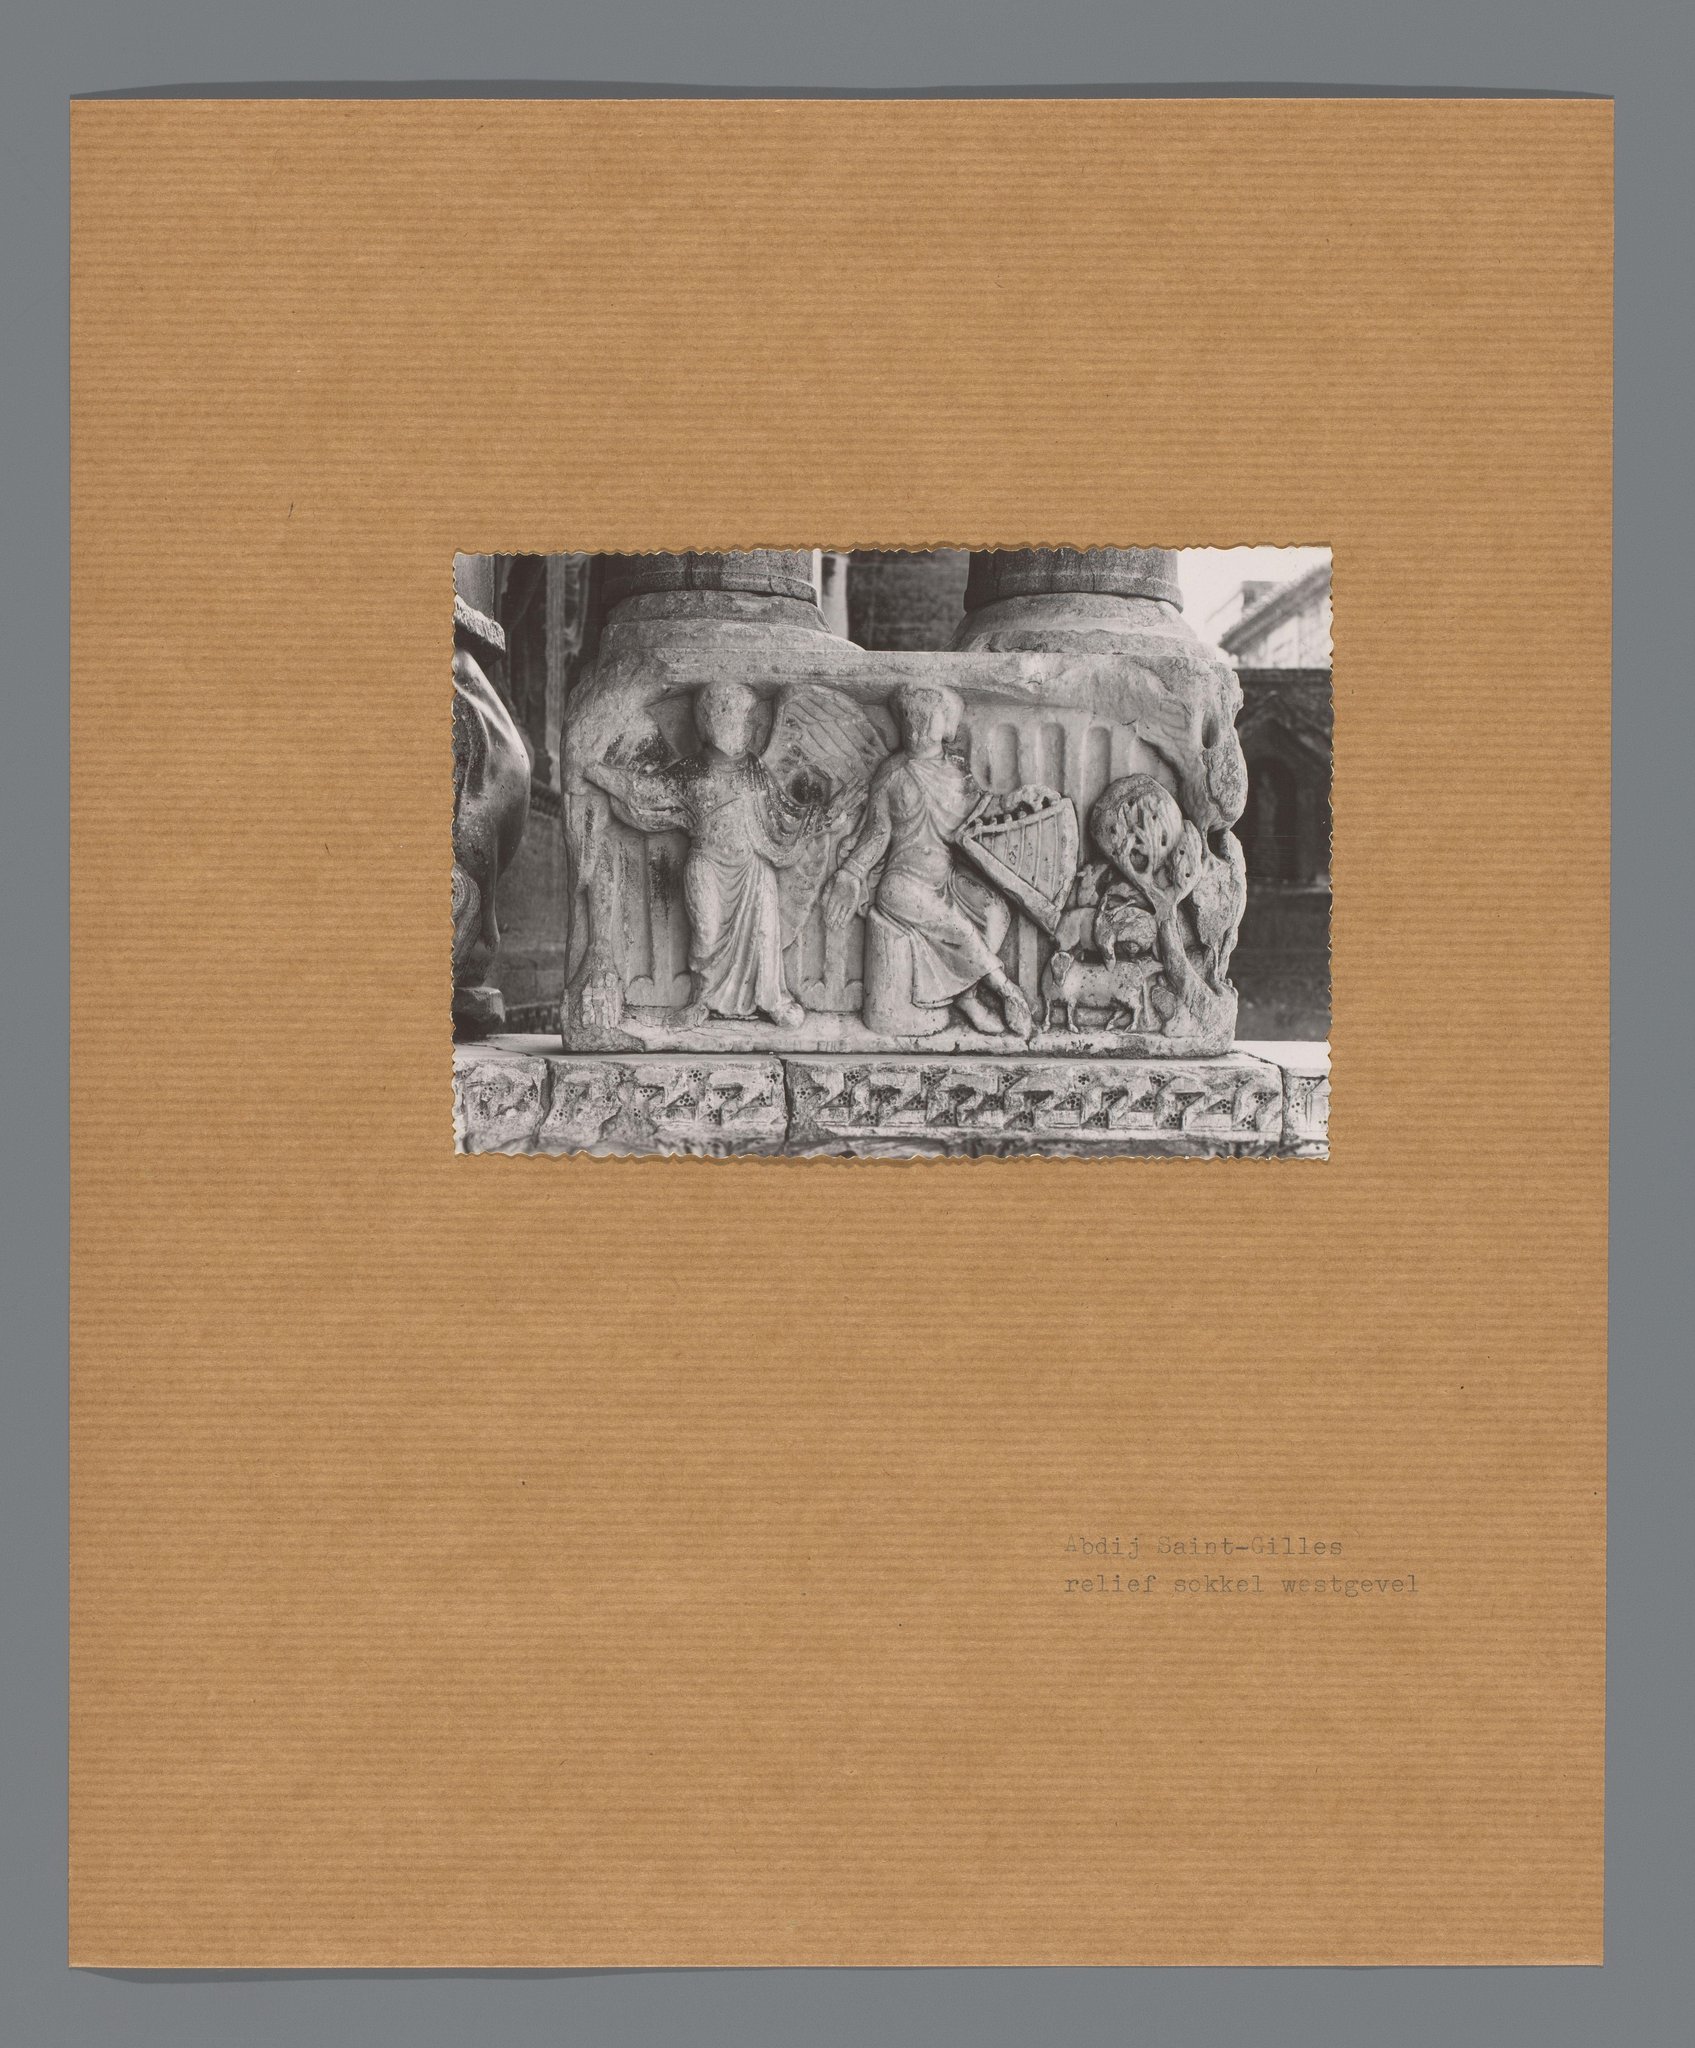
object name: photograph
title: Saint-Gilles, Kirche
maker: Anonymous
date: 1880-1930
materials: photographic support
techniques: gelatin silver print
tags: france